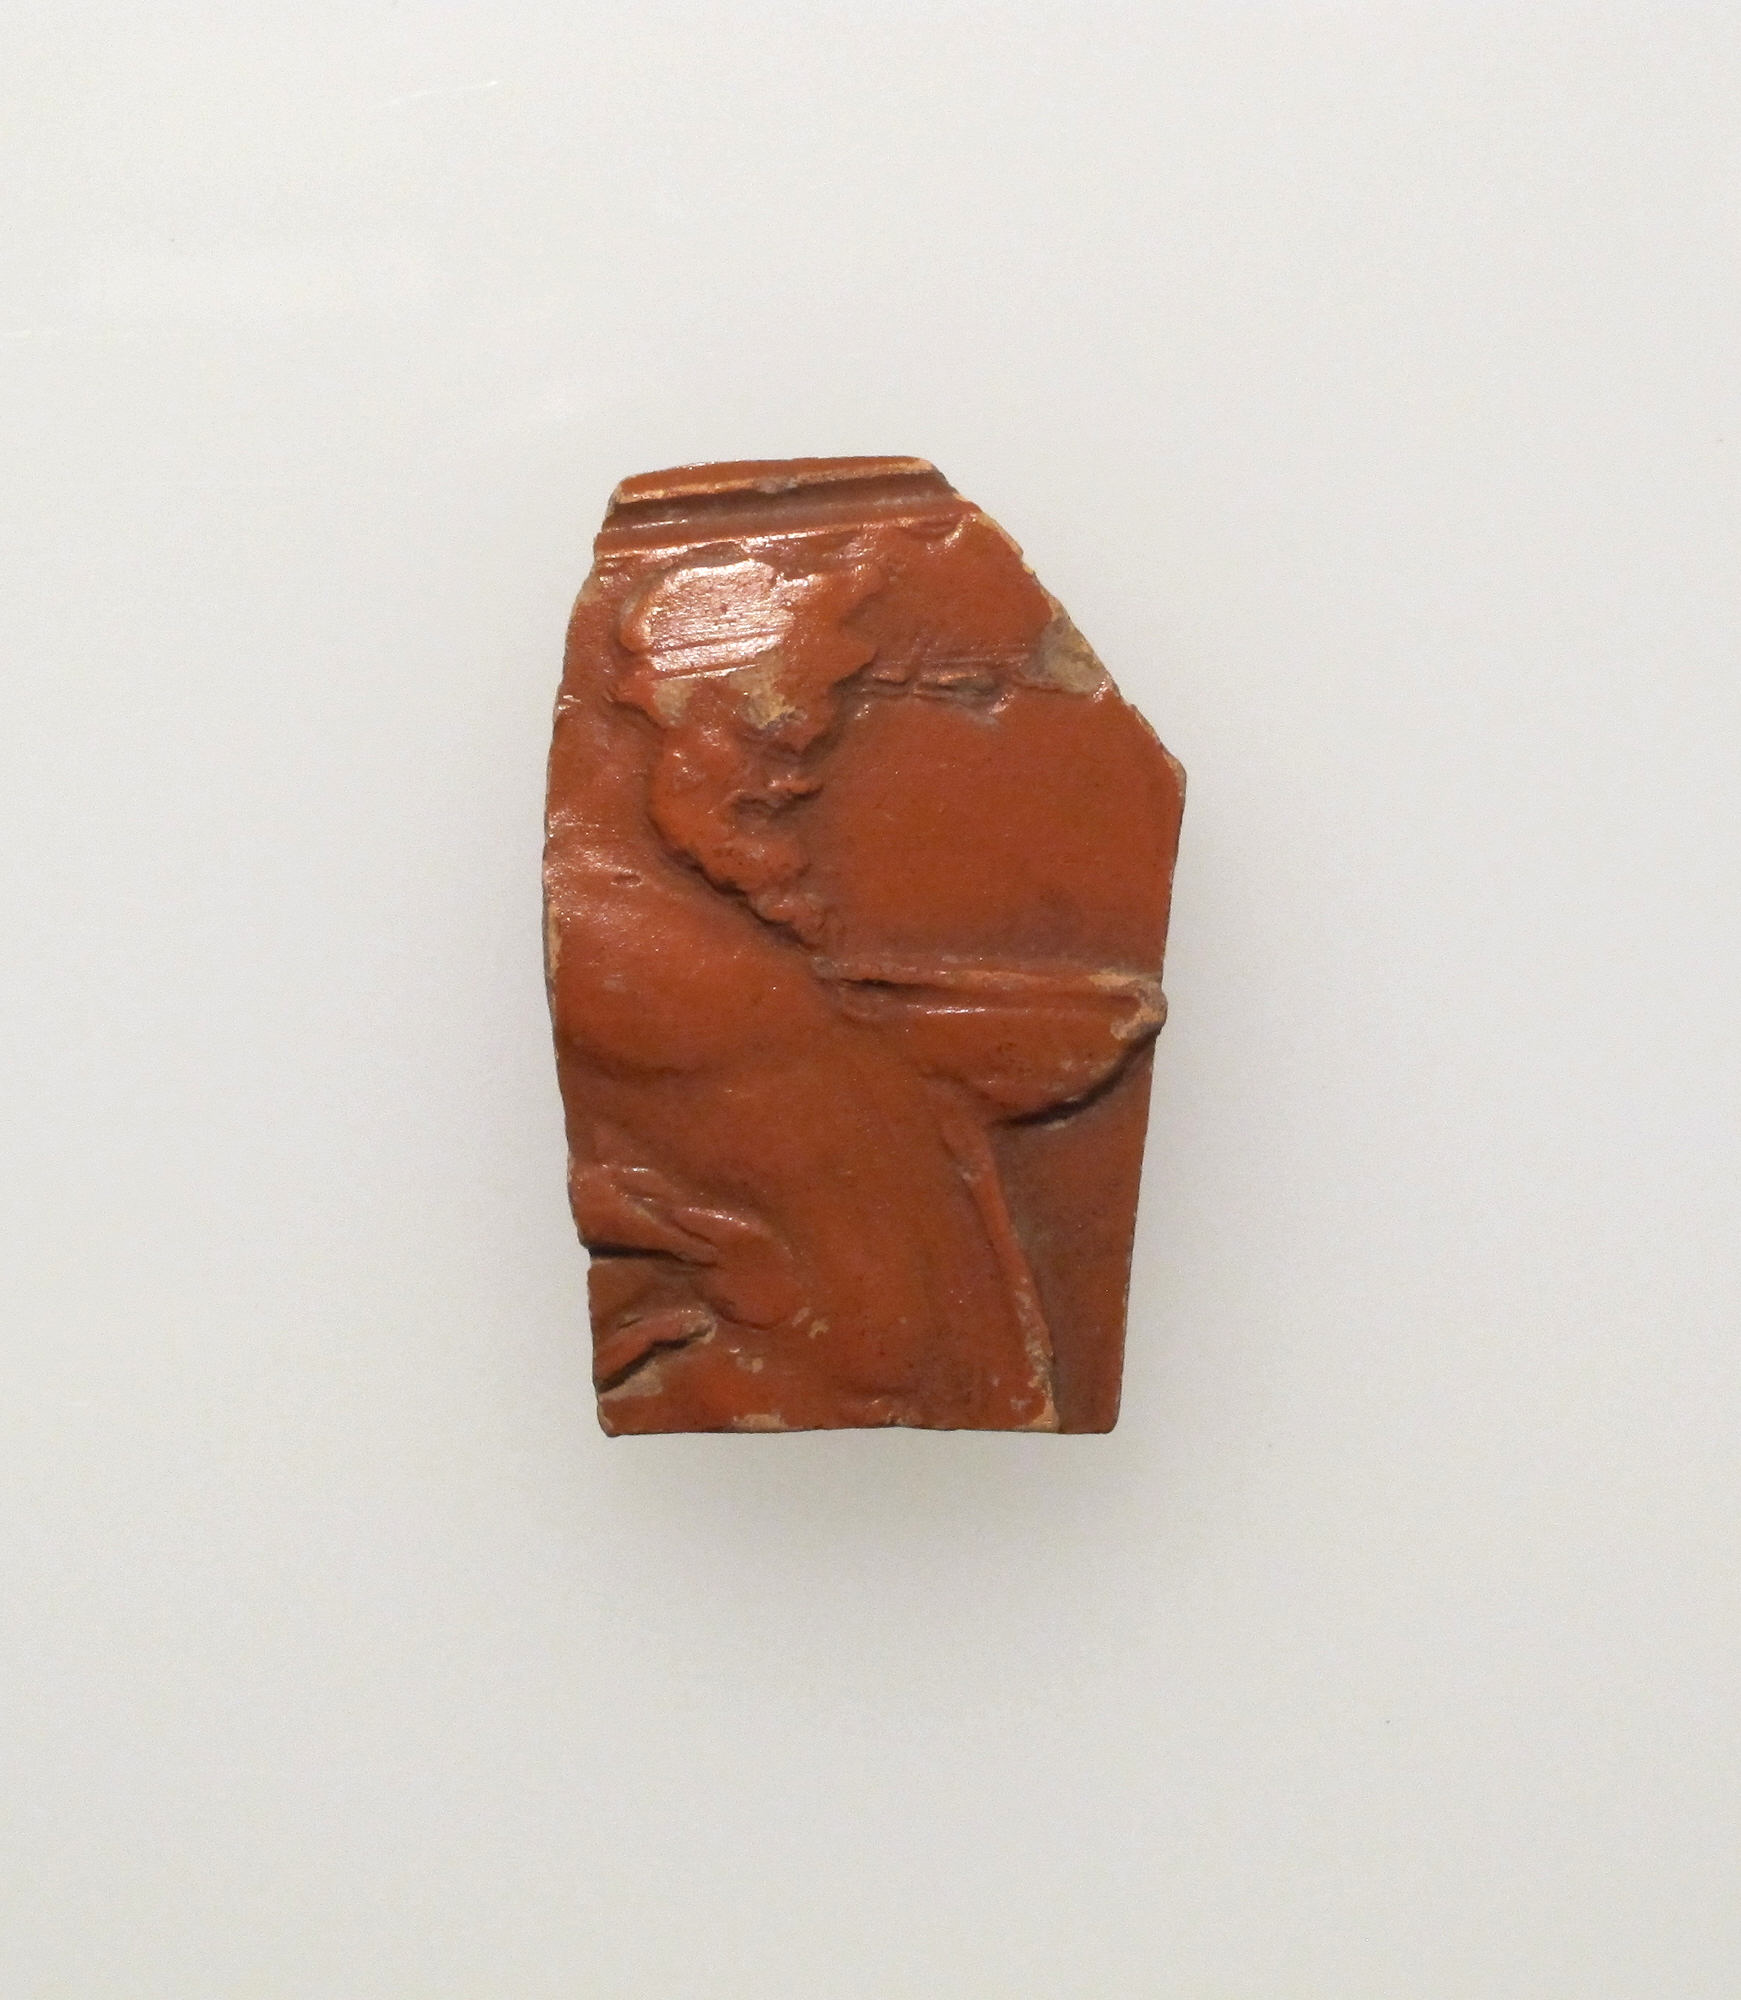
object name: vase fragment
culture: roman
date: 100 BCE-100 CE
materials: terracotta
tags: satyrs